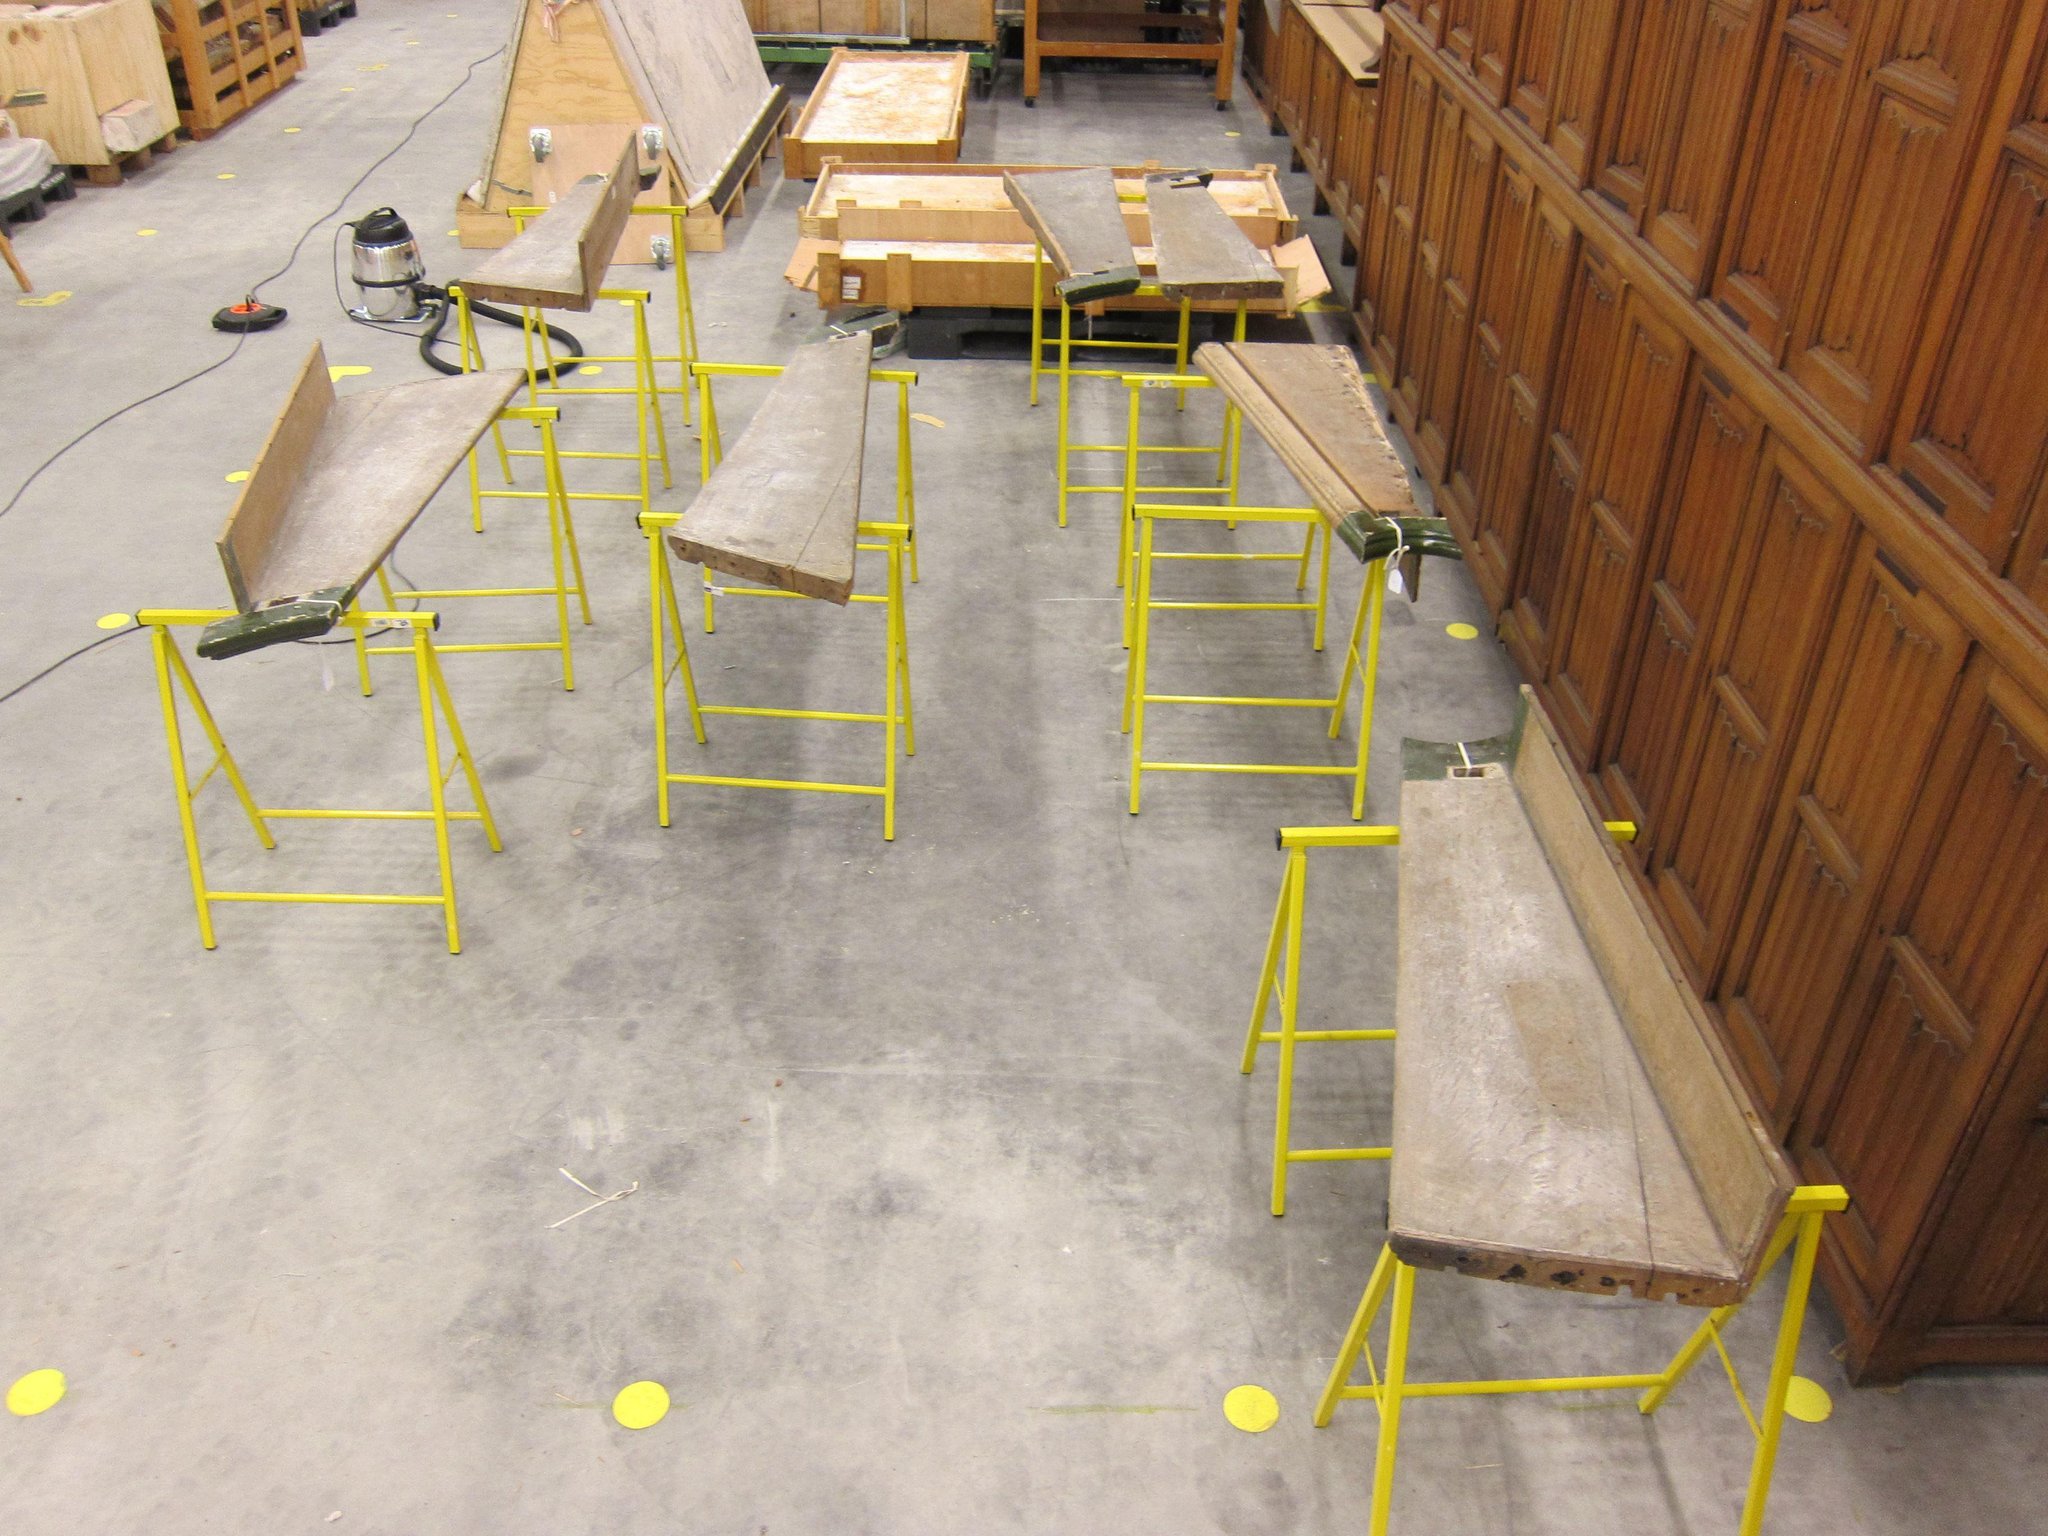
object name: architectural element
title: Onderdelen van het trapportaal uit het pand aan de Keizersgracht 187 te Amsterdam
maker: Anonymous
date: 1740-1760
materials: wood, marble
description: Onderdelen van het trapportaal uit het pand aan de Keizersgracht 187 te Amsterdam